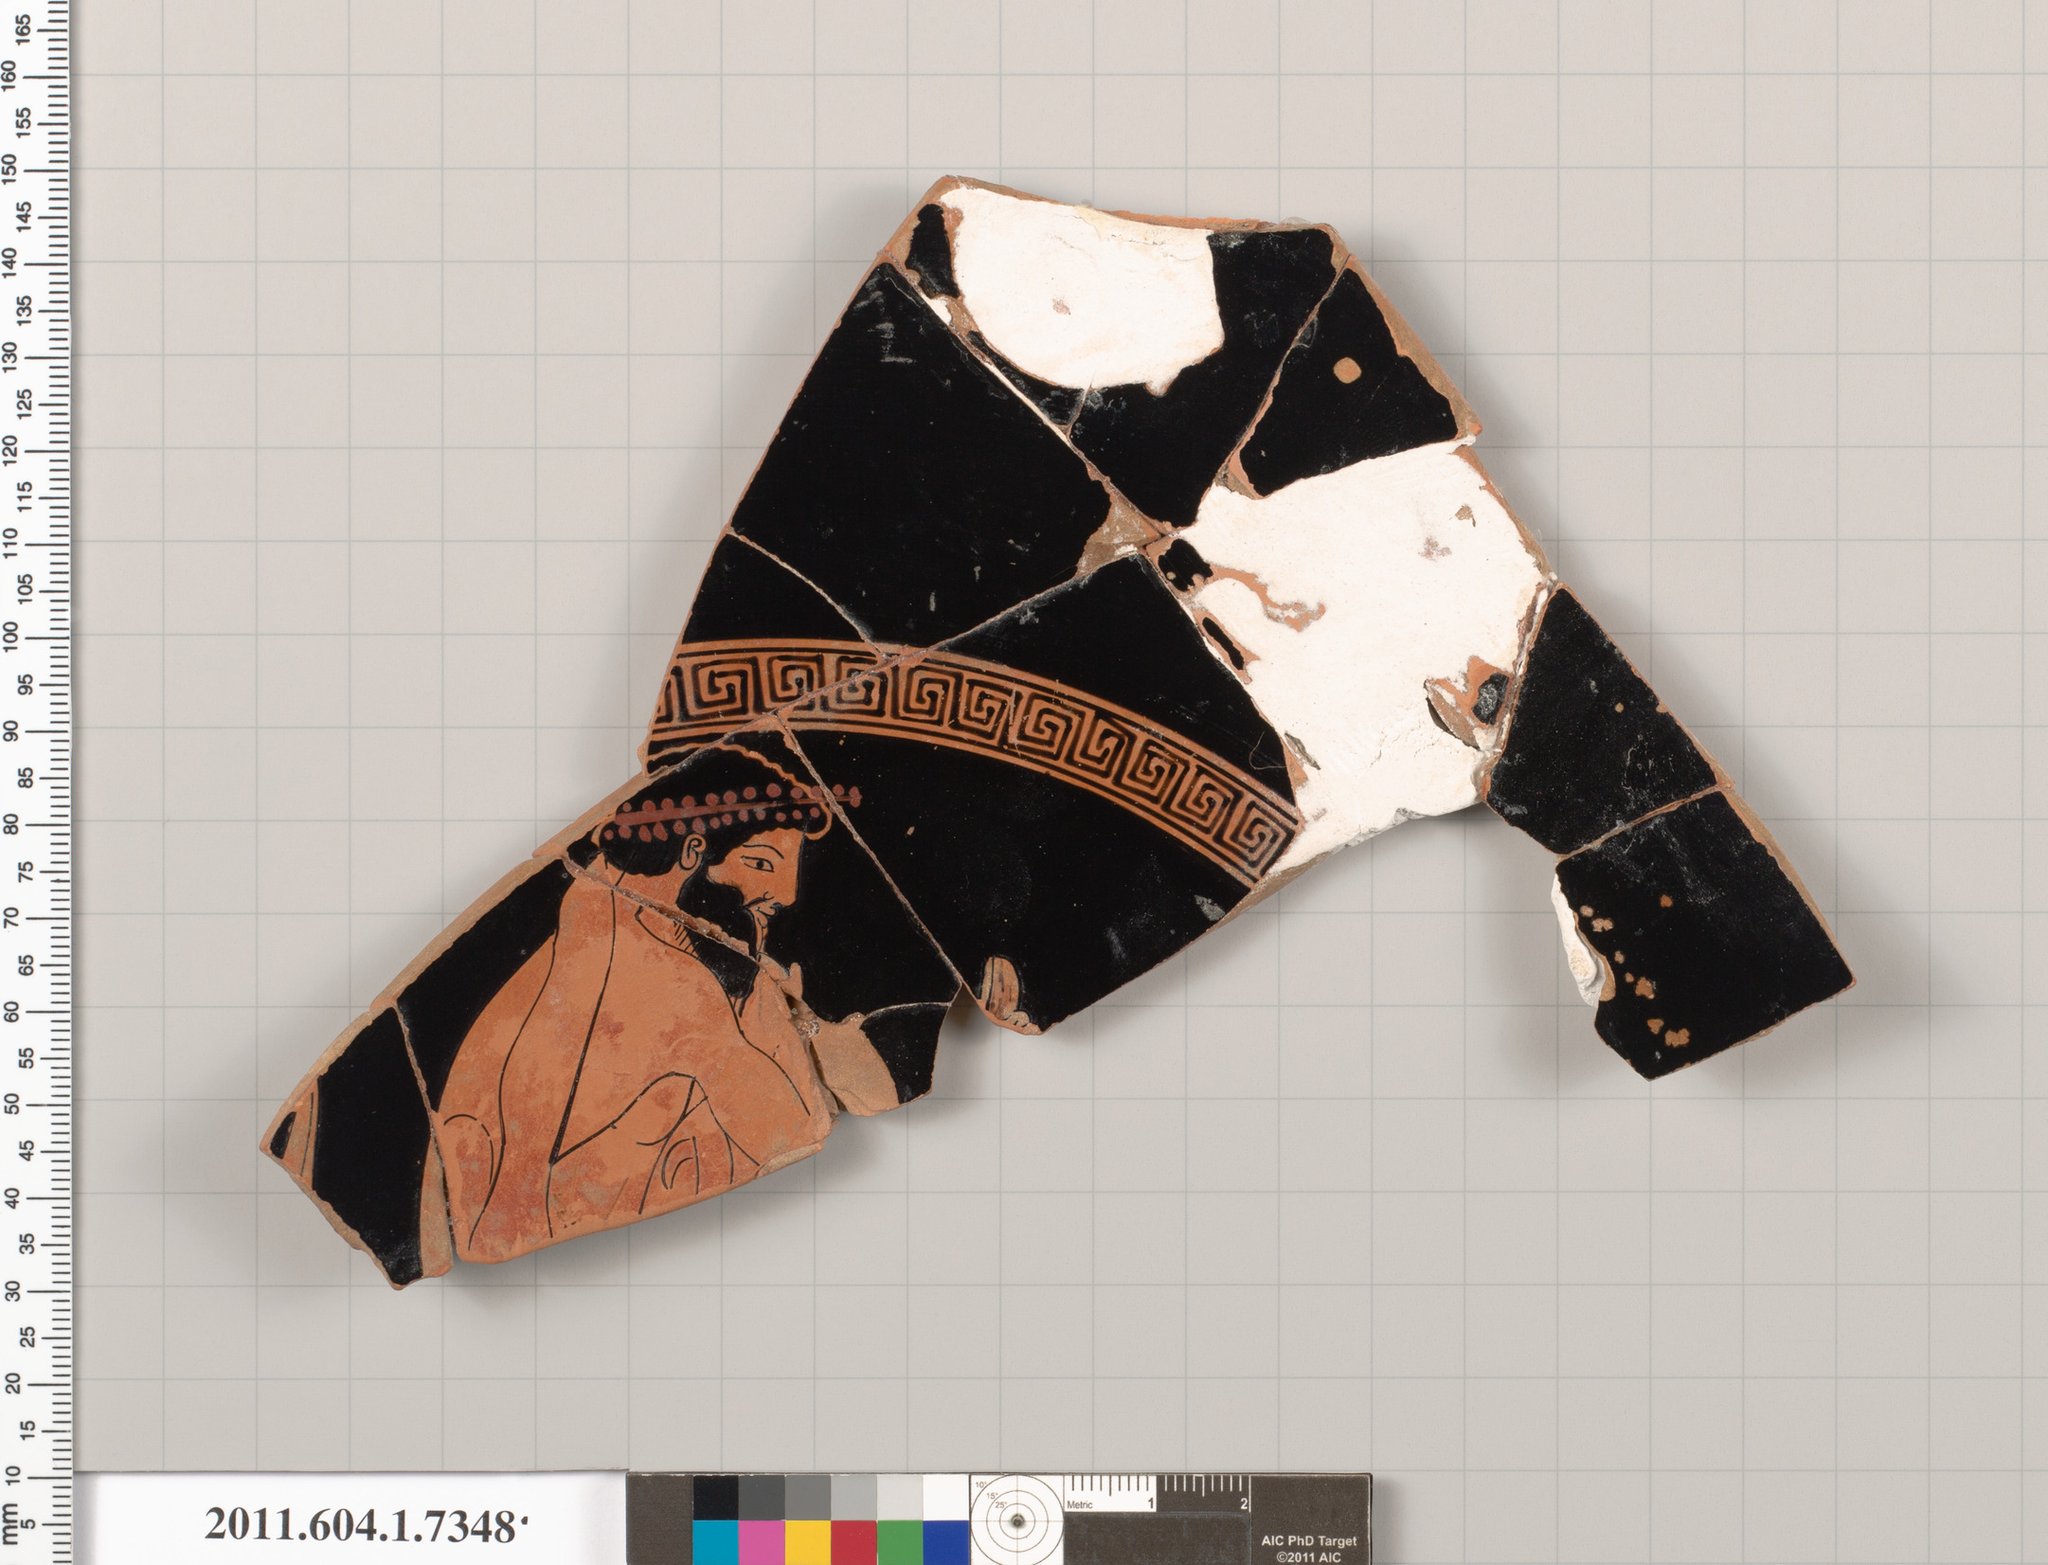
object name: kylix fragment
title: Terracotta fragment of a kylix (drinking cup)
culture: greek, attic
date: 500-480 BCE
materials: terracotta